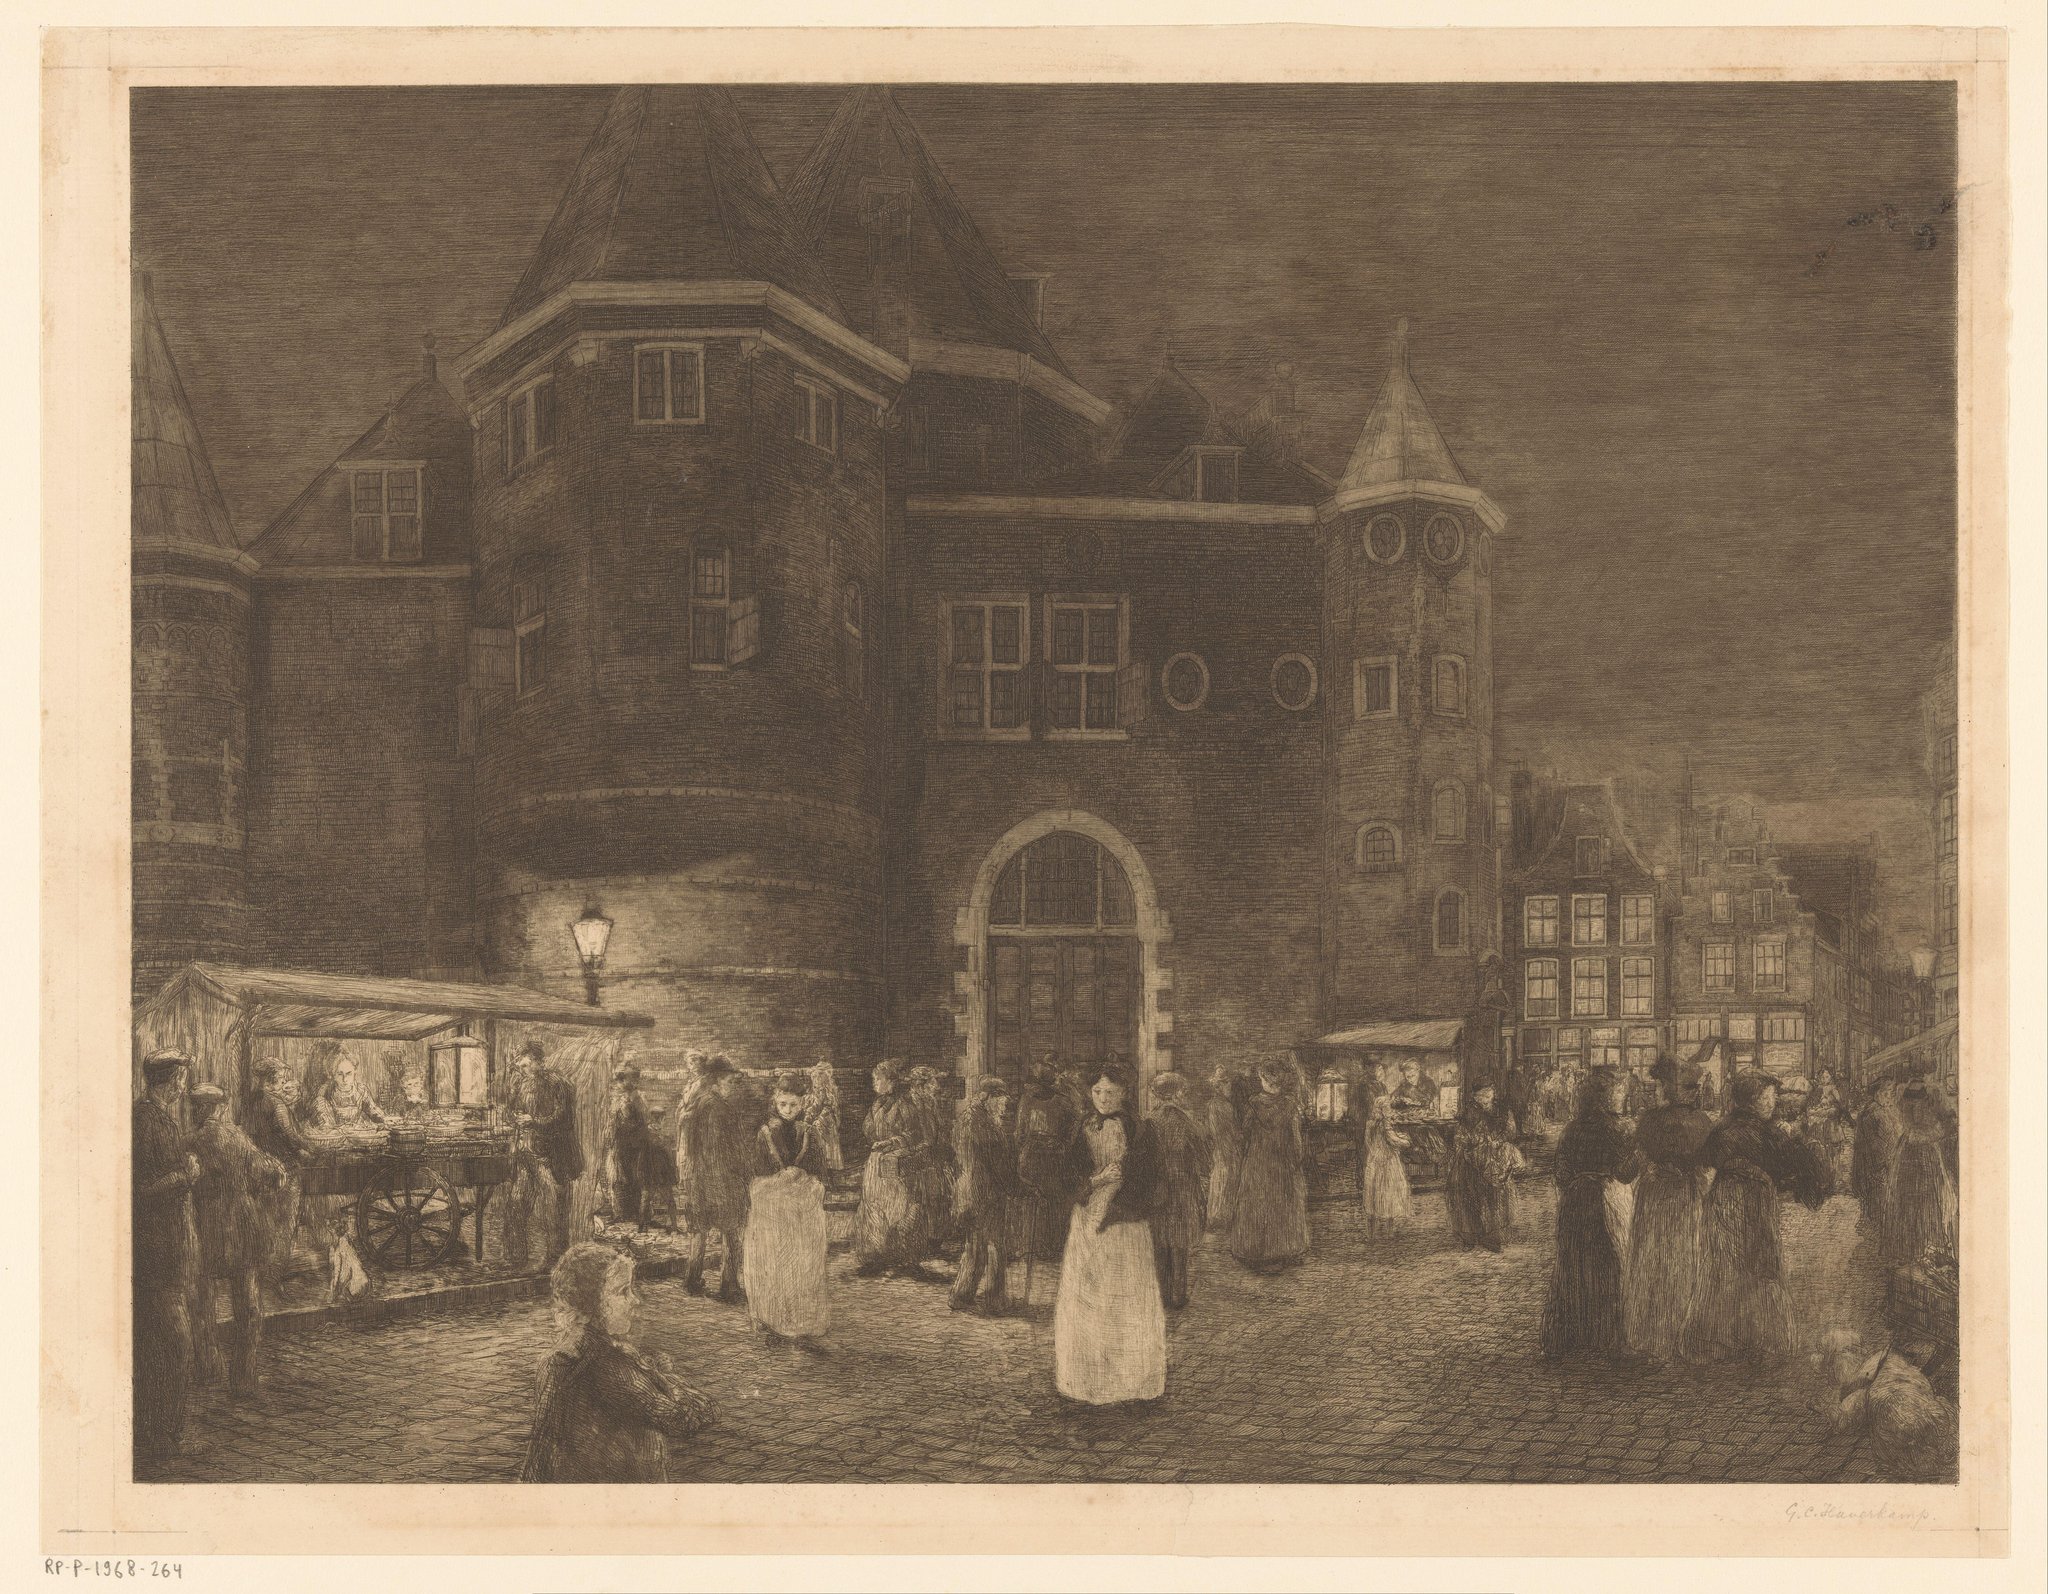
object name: print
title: Markt bij de Waag op de Nieuwmarkt in Amsterdam bij avond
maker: gerrit haverkamp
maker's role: print maker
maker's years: 1872-1926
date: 1882-1926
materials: paper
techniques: etching, intaglio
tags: evening, market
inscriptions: collector's mark: Lugt 2228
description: Rechts op de achtergrond huizen op de hoek van de Nieuwmarkt met de Monnikenstraat.